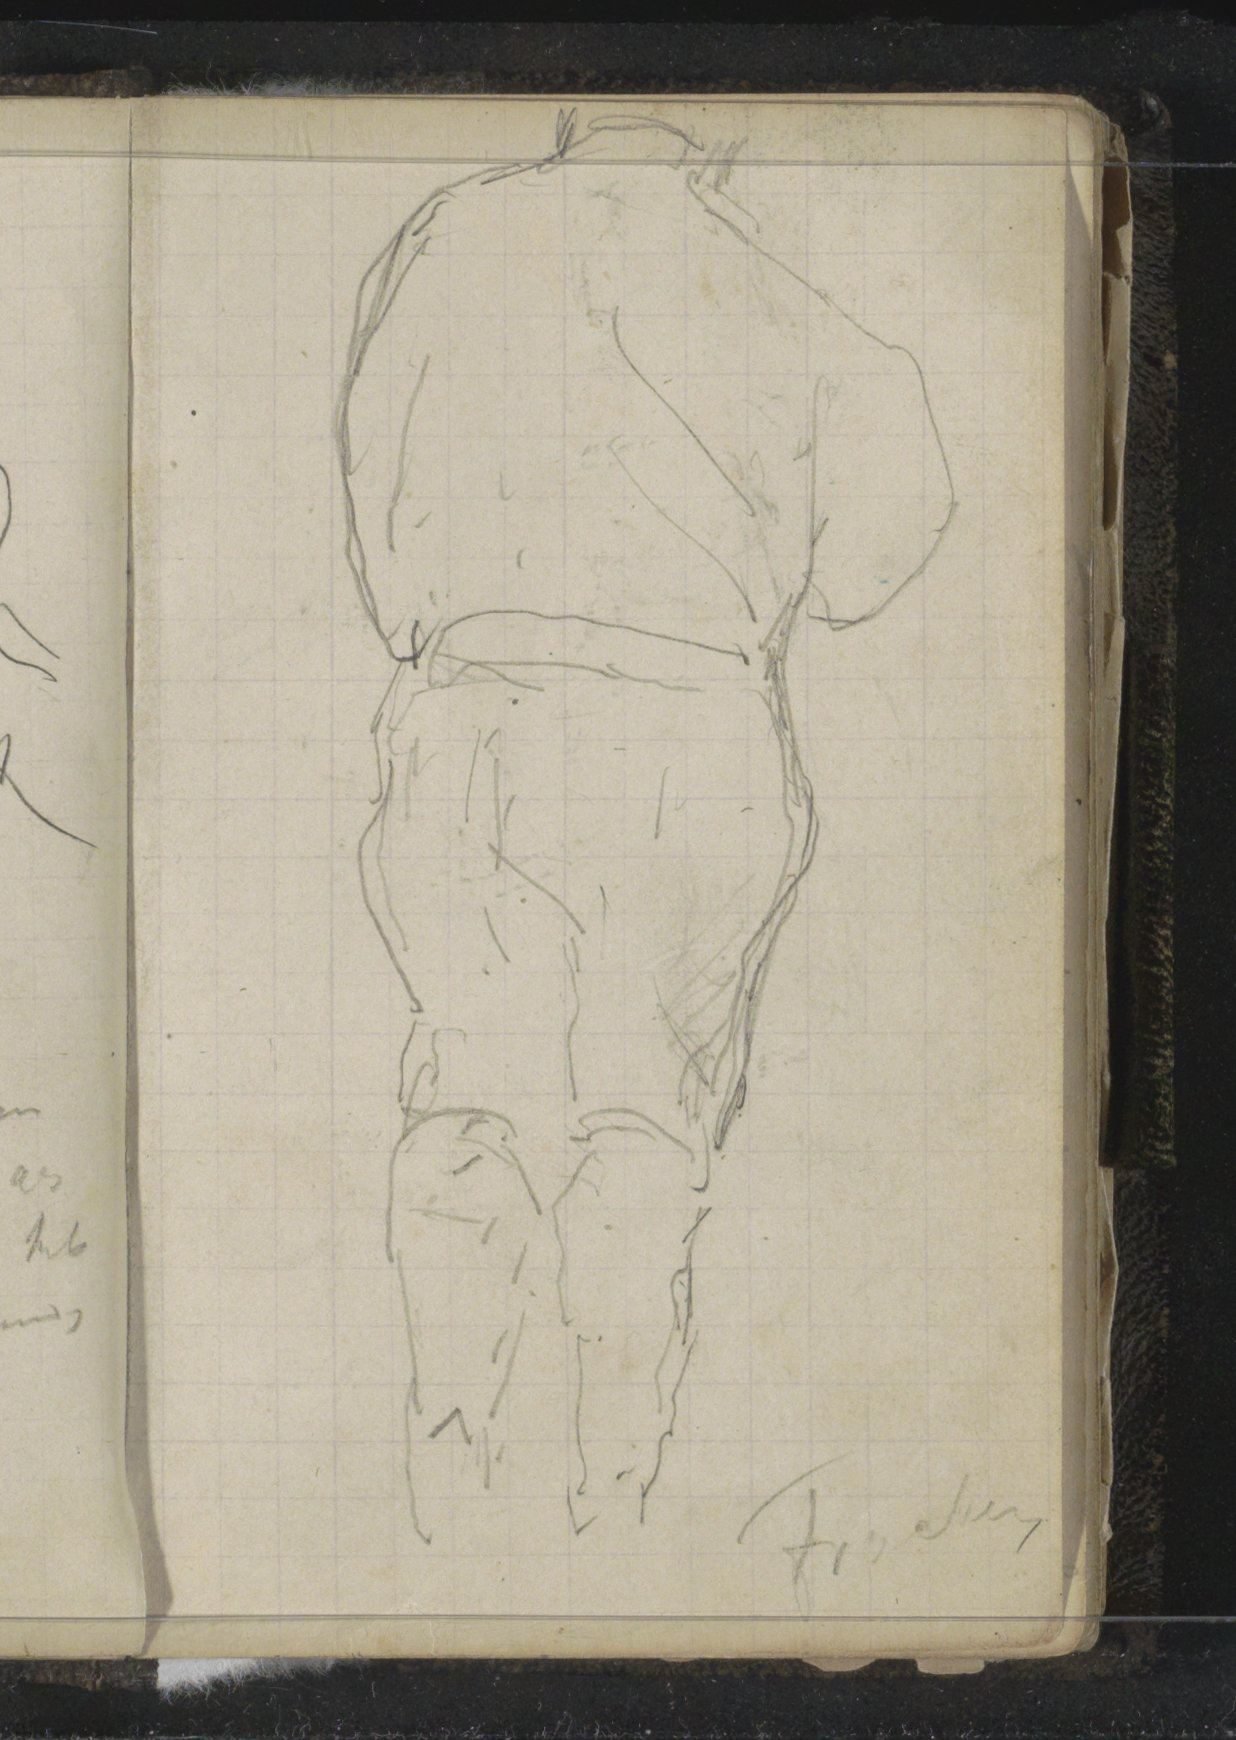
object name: sketchbook leaf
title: Staande man, op de rug gezien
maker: louis apol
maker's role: draughtsman, painter, print maker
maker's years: 1850-1936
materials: pencil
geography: barentsz sea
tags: sailor, adult man (+ standing)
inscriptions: annotation: ‘[...]’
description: Mogelijk een bemanningslid van de Willem Barentsz. Blad 20 recto uit een schetsboek met 110 bladen betekend tijdens de expeditie naar Nova Zembla in 1880.